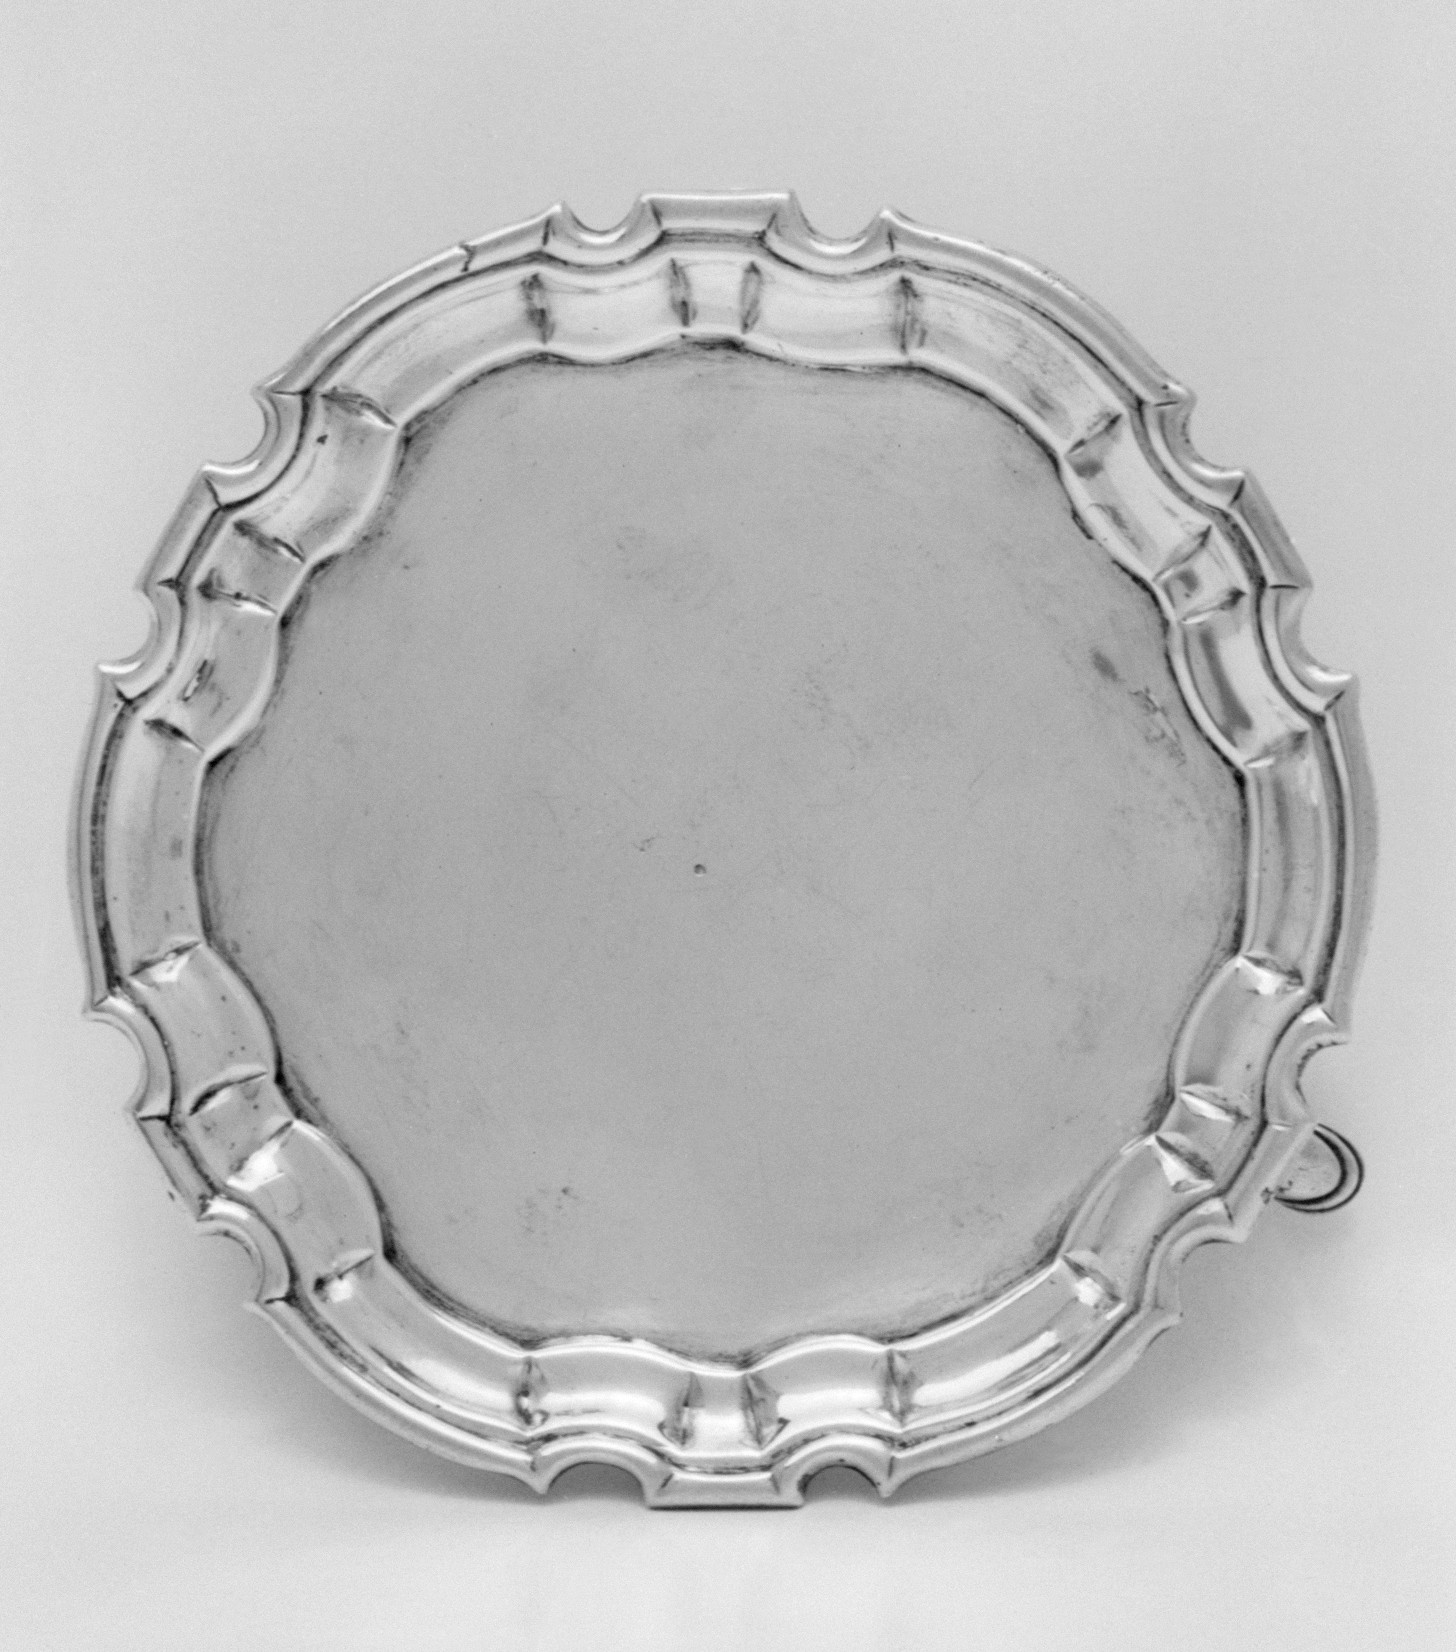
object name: salver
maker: w. d.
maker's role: maker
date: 1735-1750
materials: silver